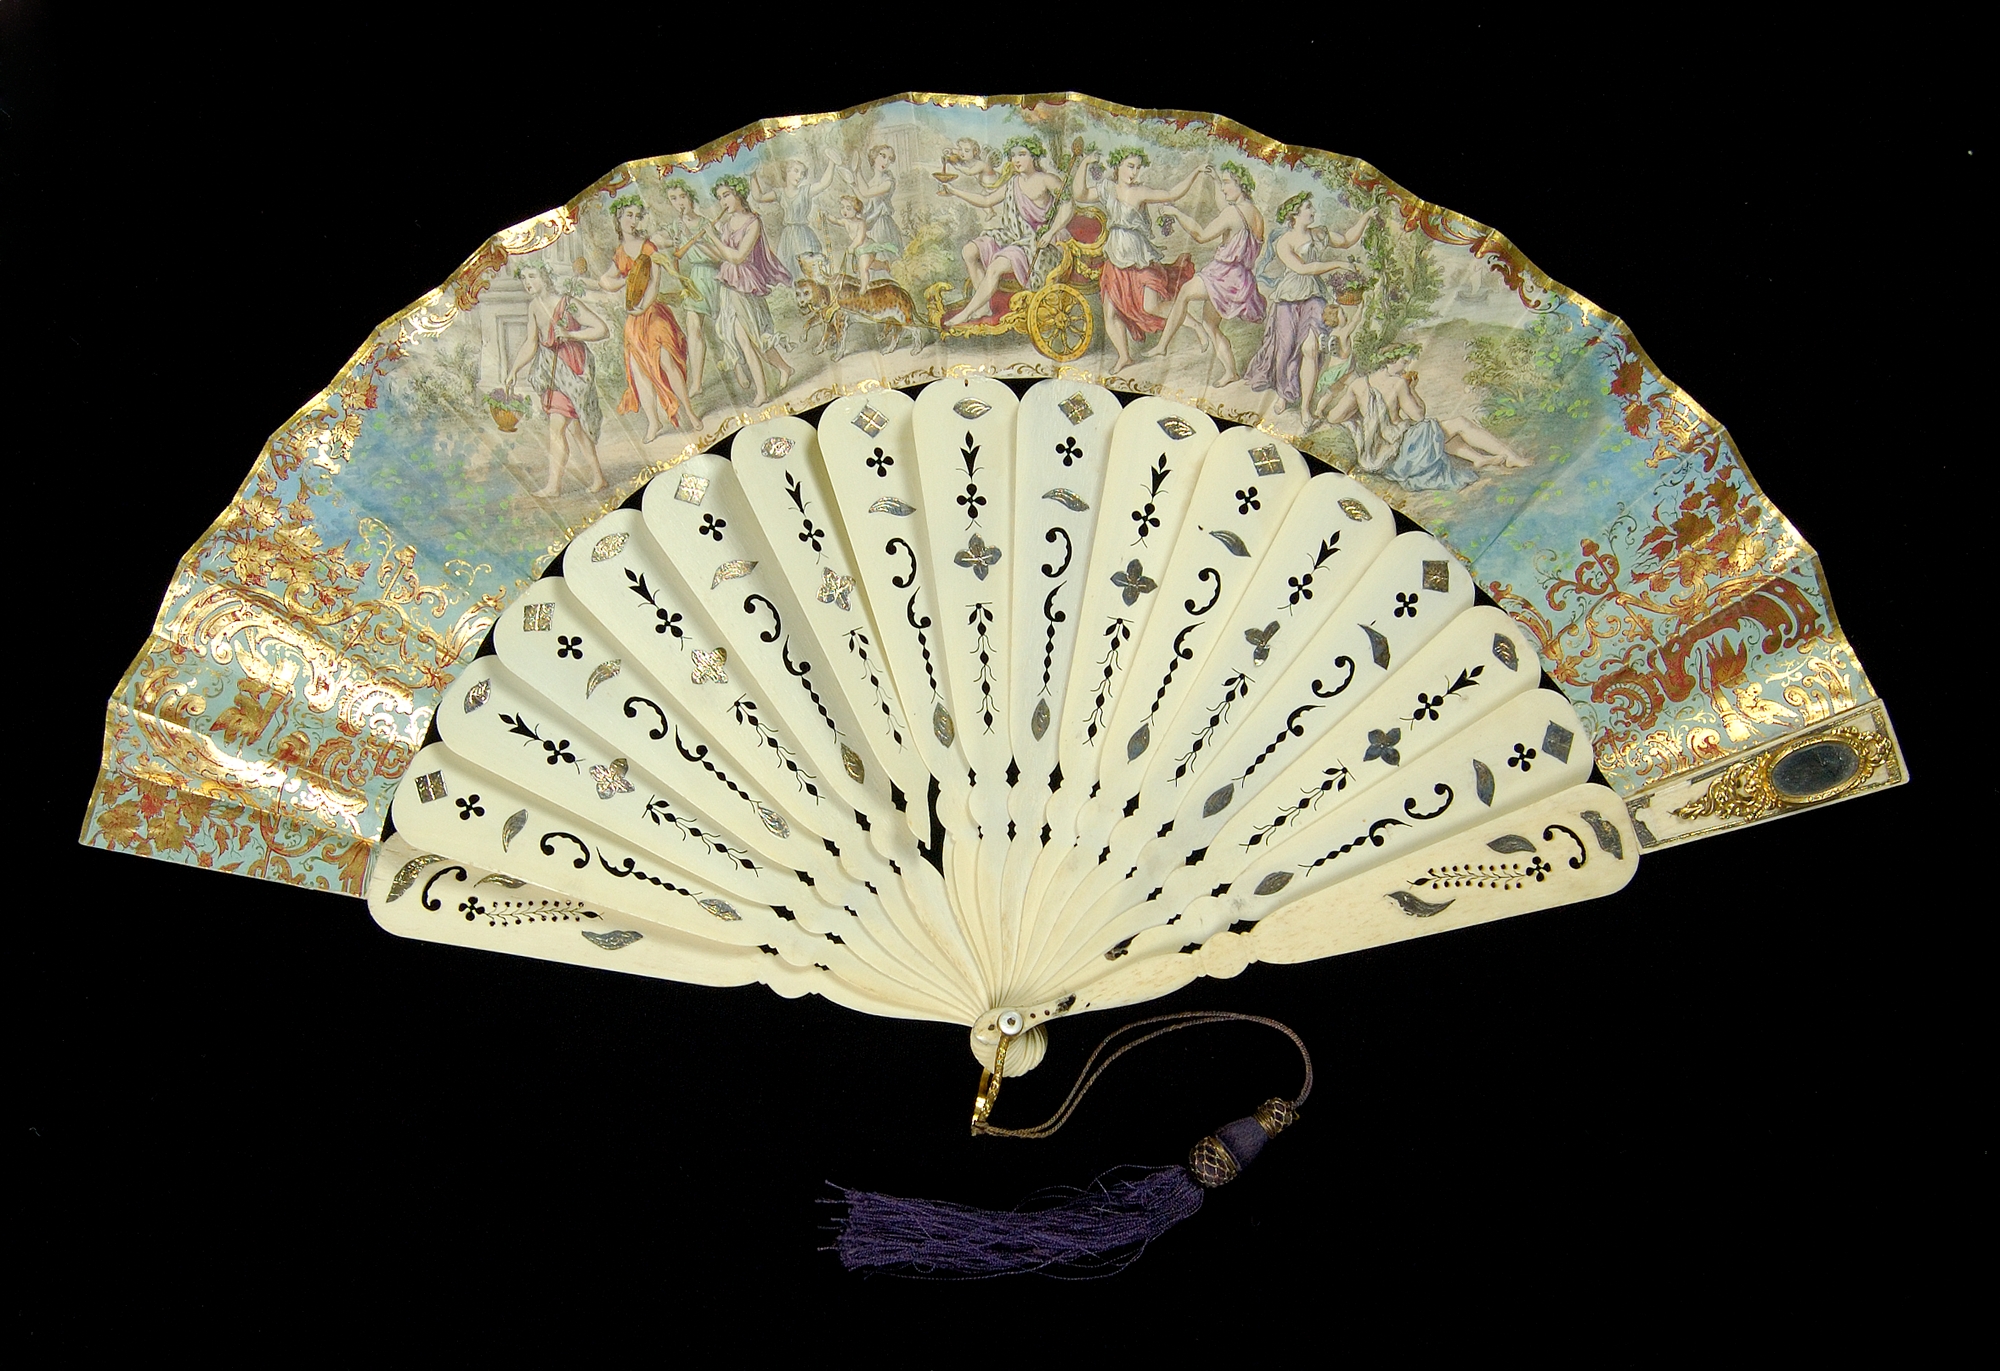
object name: fan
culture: spanish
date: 1860-1869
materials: glass, ivory, metal, mother of pearl, paper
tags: women,leopards,chariots